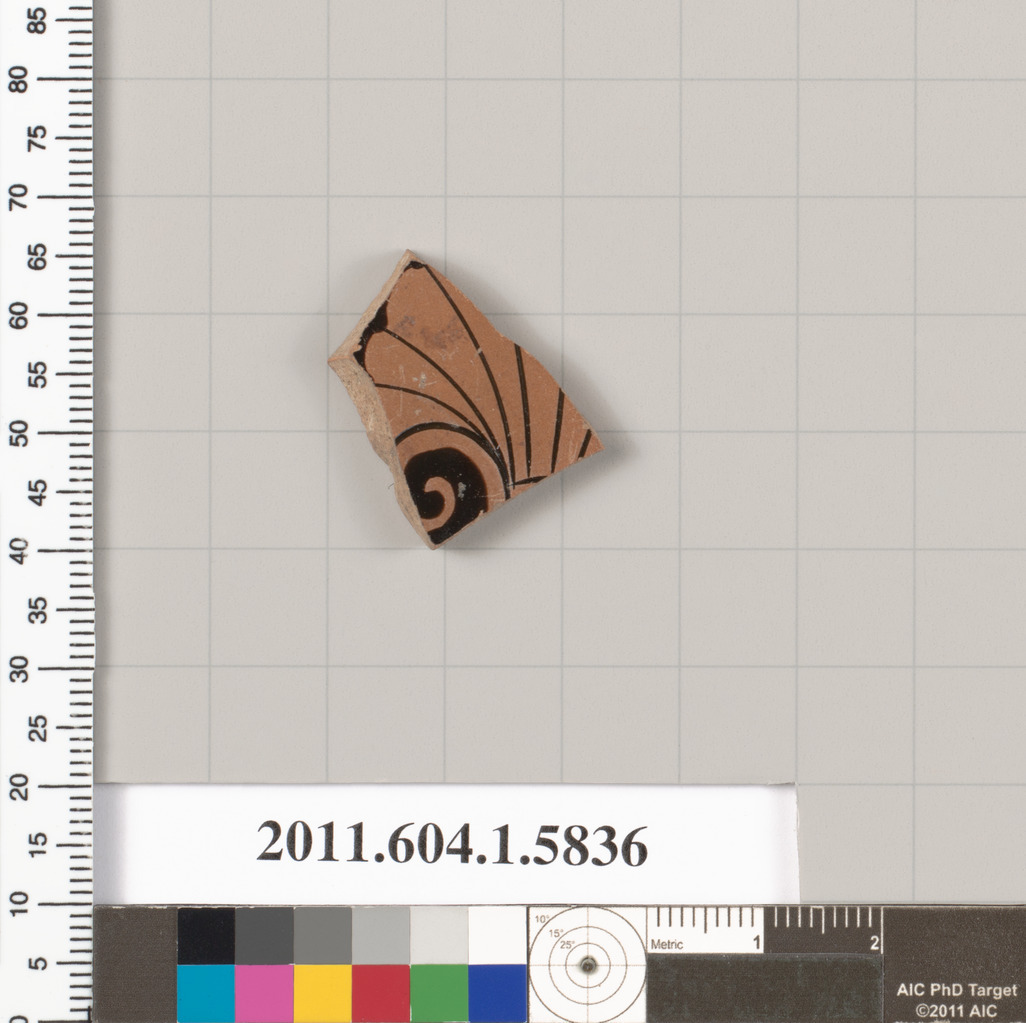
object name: kylix fragment, eye cup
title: Terracotta fragment of a kylix: eye-cup (drinking cup)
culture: greek, attic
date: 520-510 BCE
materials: terracotta